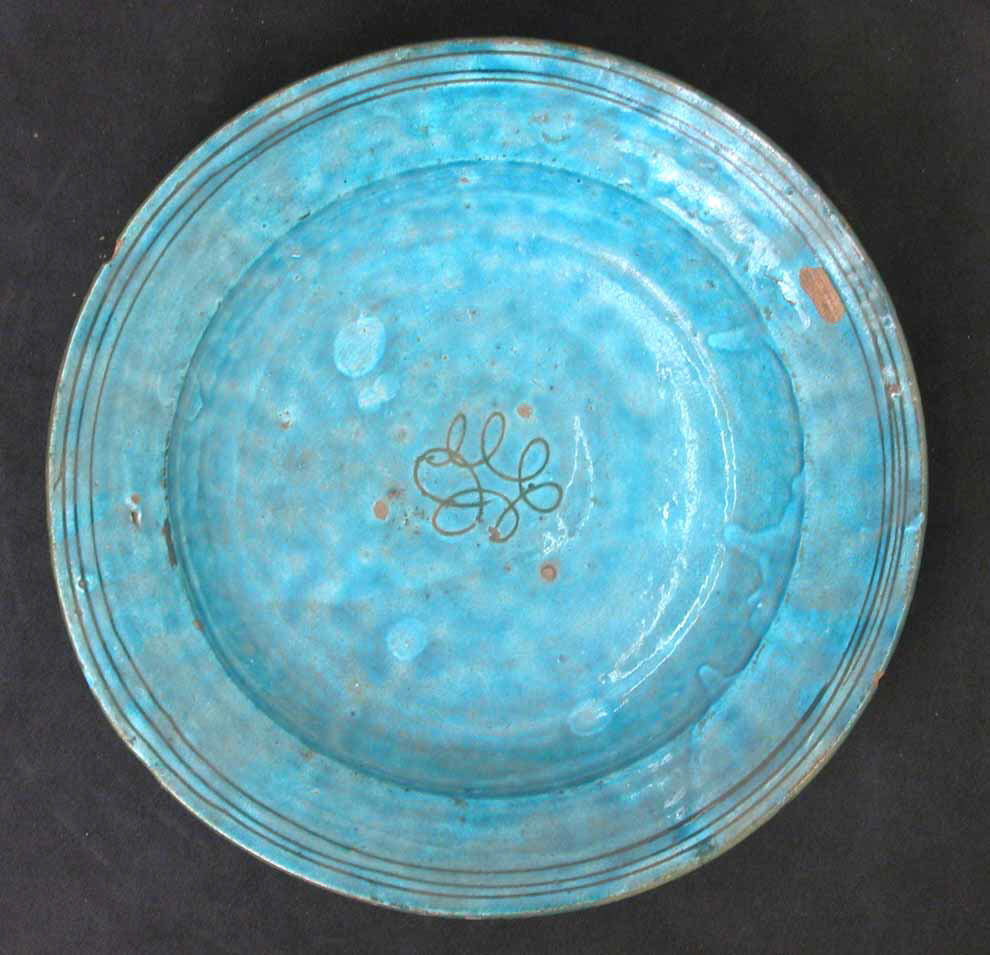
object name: dish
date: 1701-1900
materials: stonepaste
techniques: glazing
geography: iran